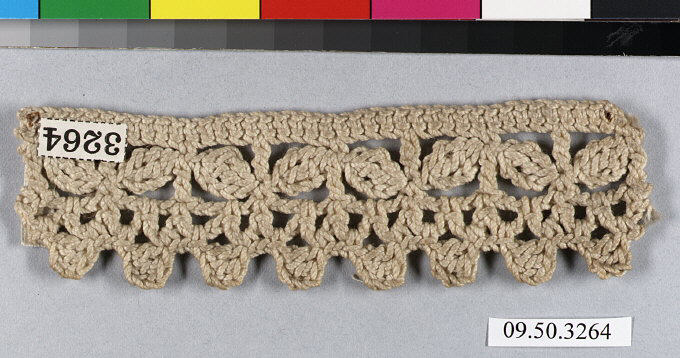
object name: sample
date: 1801-1900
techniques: crochet